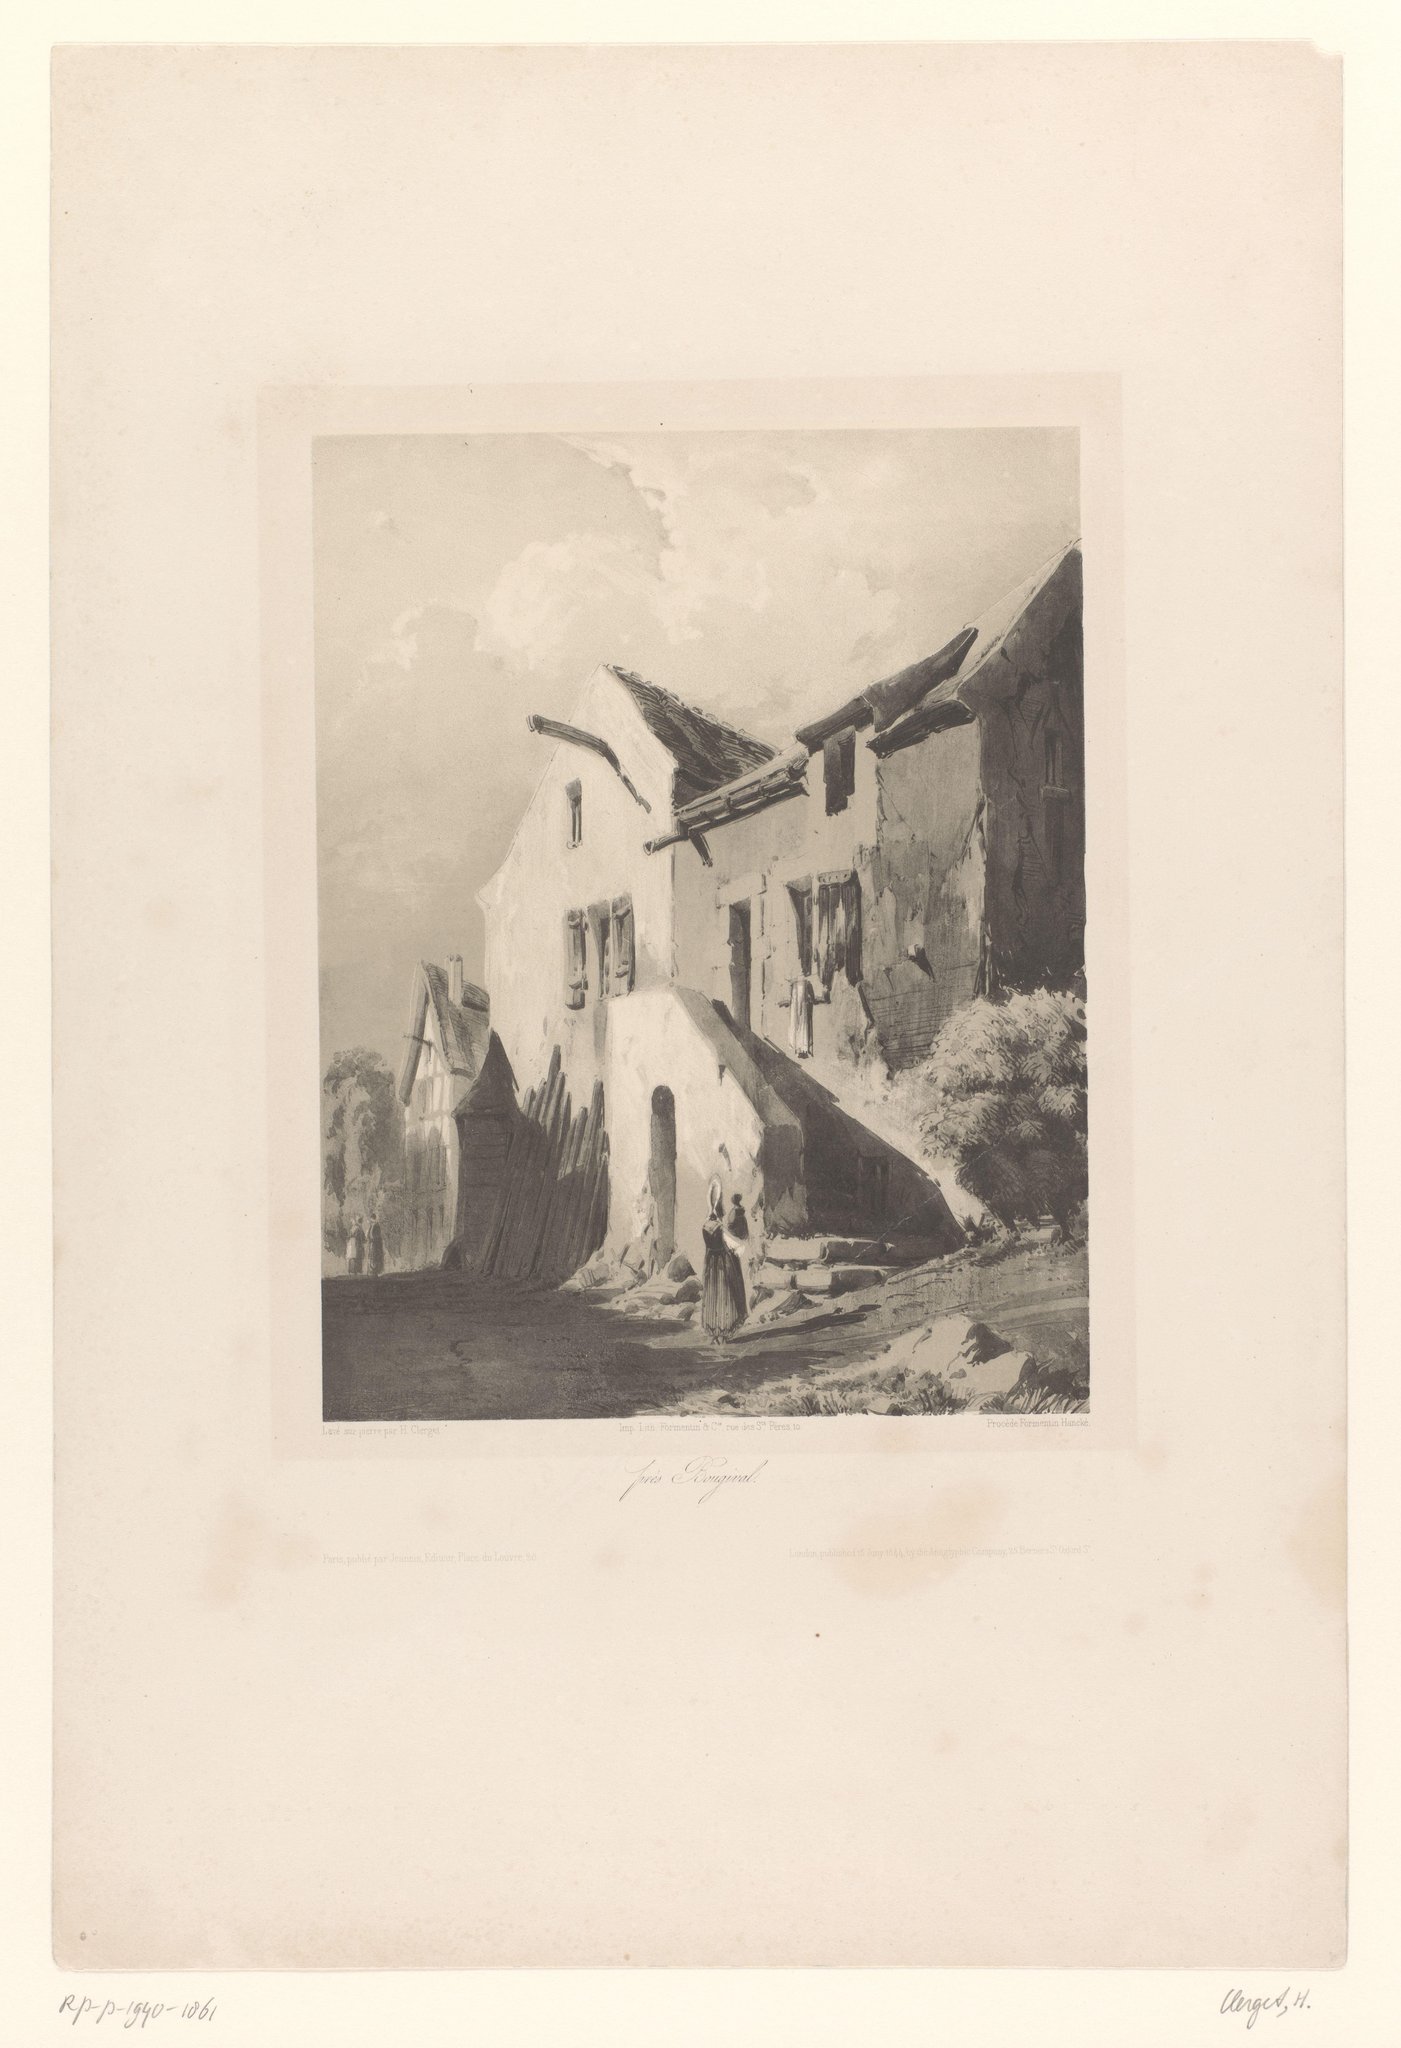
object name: print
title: Huizen in de buurt van Bougival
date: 1840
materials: paper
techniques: tone lithography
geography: london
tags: country-house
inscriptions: collector's mark: Lugt 2228a